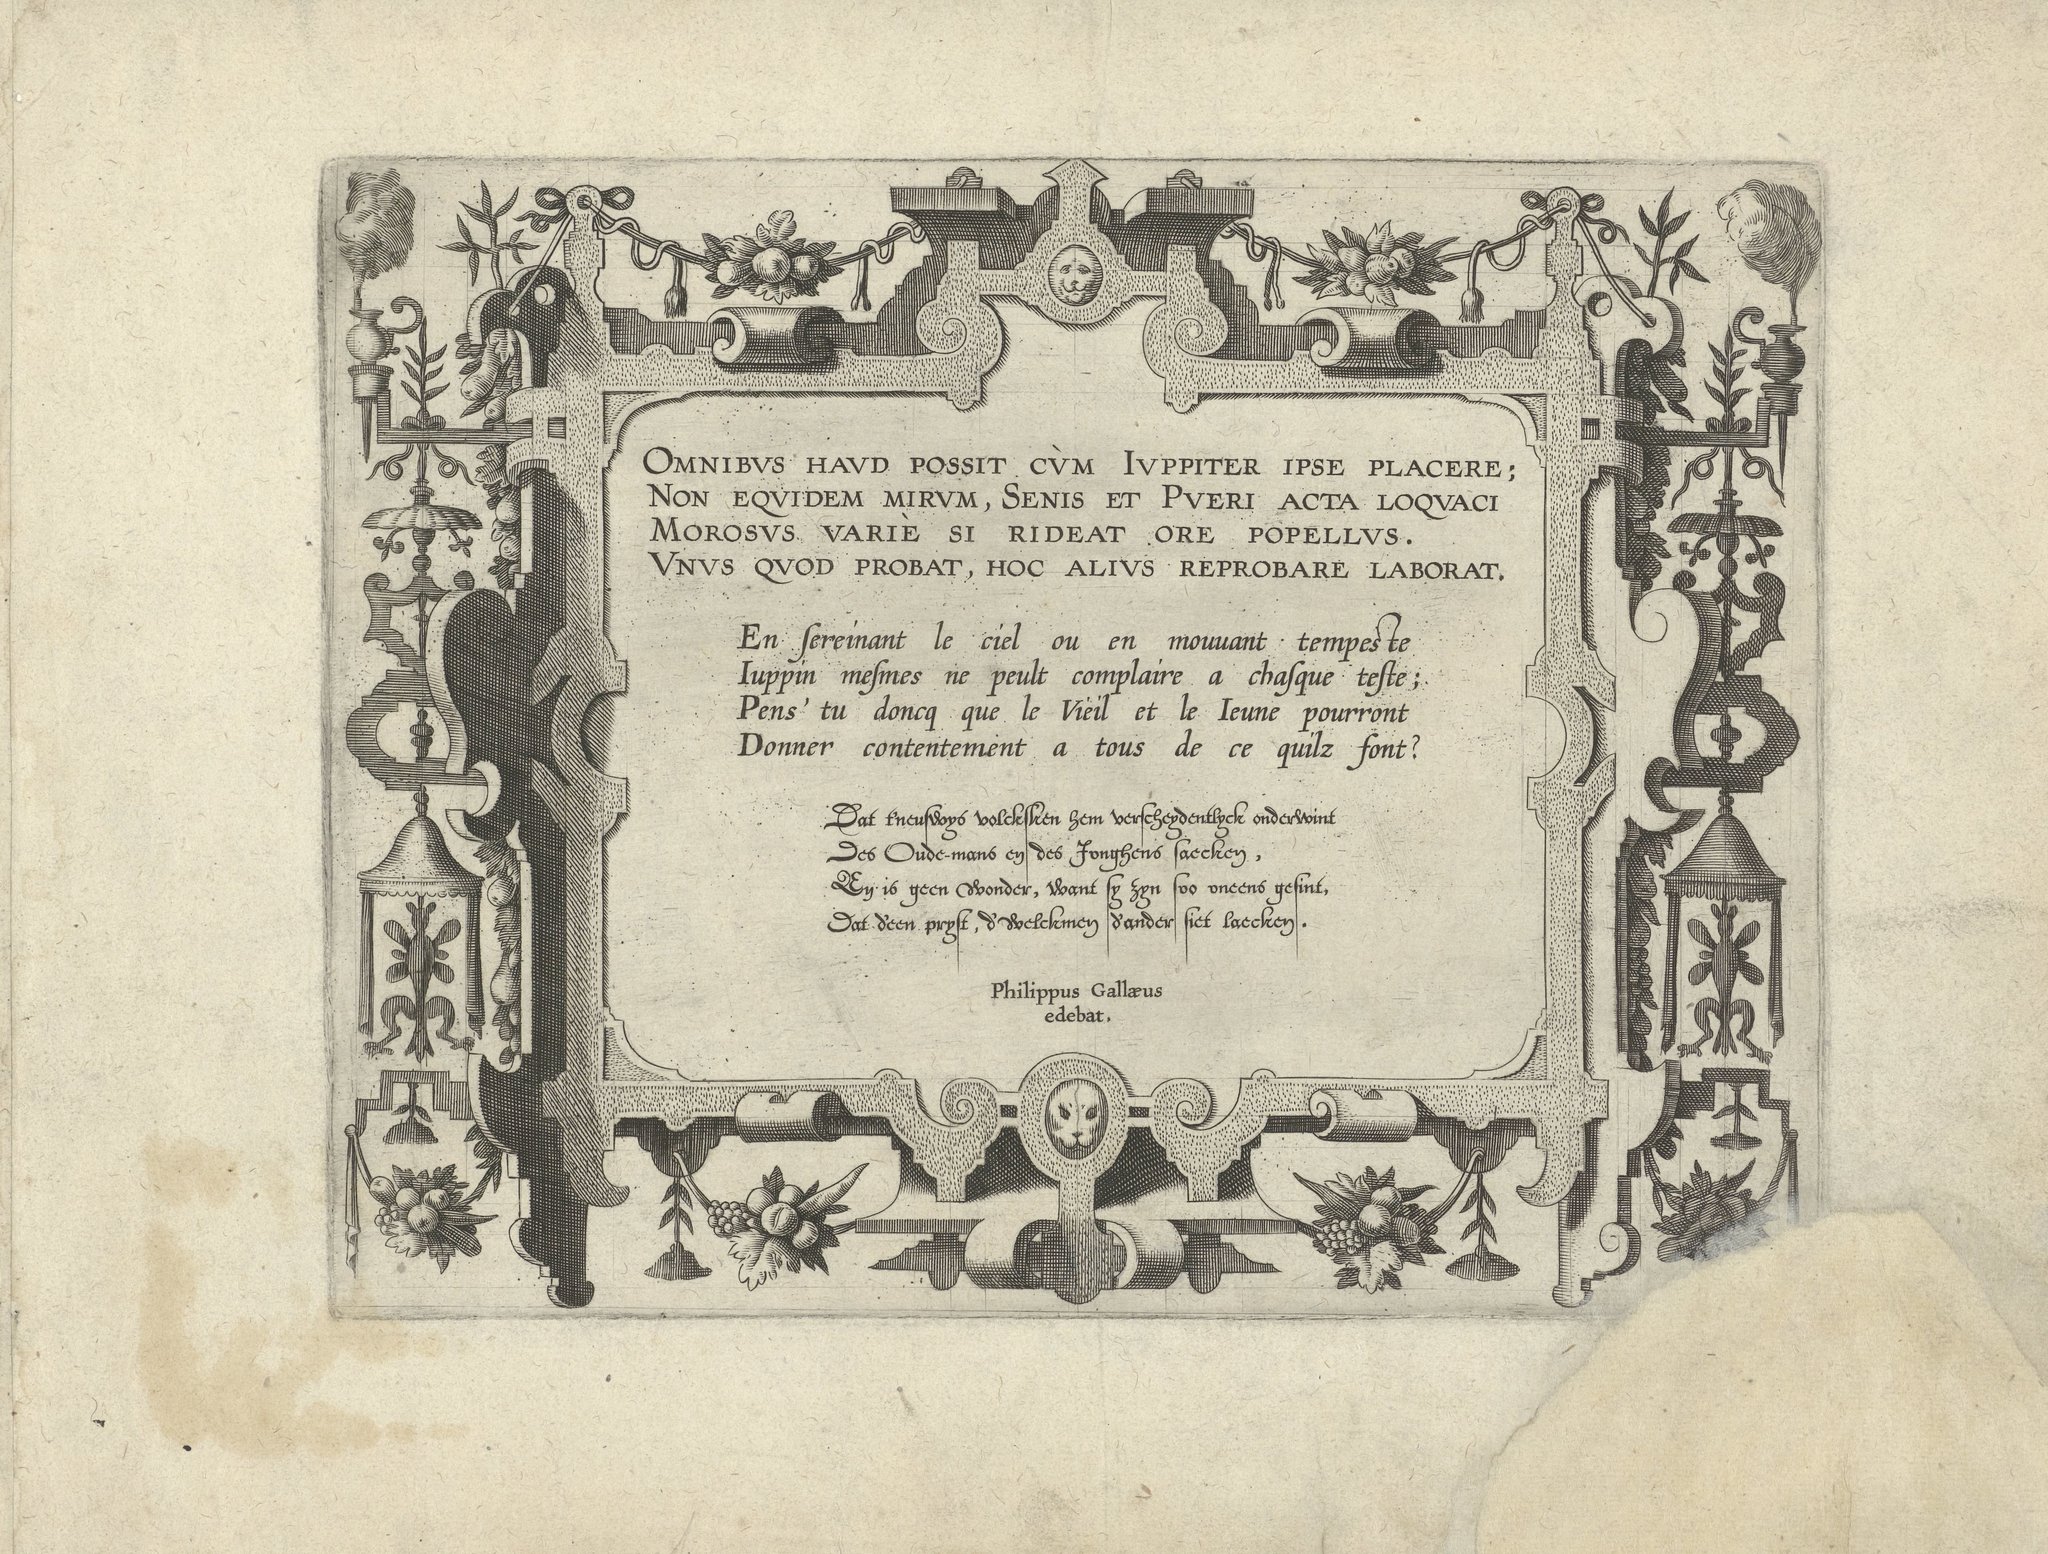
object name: print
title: Titelprent voor de fabel van de vader, de zoon en de ezel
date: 1570-1612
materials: paper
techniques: engraving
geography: antwerp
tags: fable of the father, son and ass, title-page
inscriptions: collector's mark: Lugt 2228, collector's mark: Lugt 2760, collector's mark: Lugt 3751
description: Titelprent van serie prenten met de verbeelding van de Aisopische fabel over de vader, de zoon en de ezel. De moraal van het verhaal is dat wanneer men iedereen probeert tevreden te stellen, je uiteindelijk niemand tevreden stelt. Eerste prent van een serie van zes.